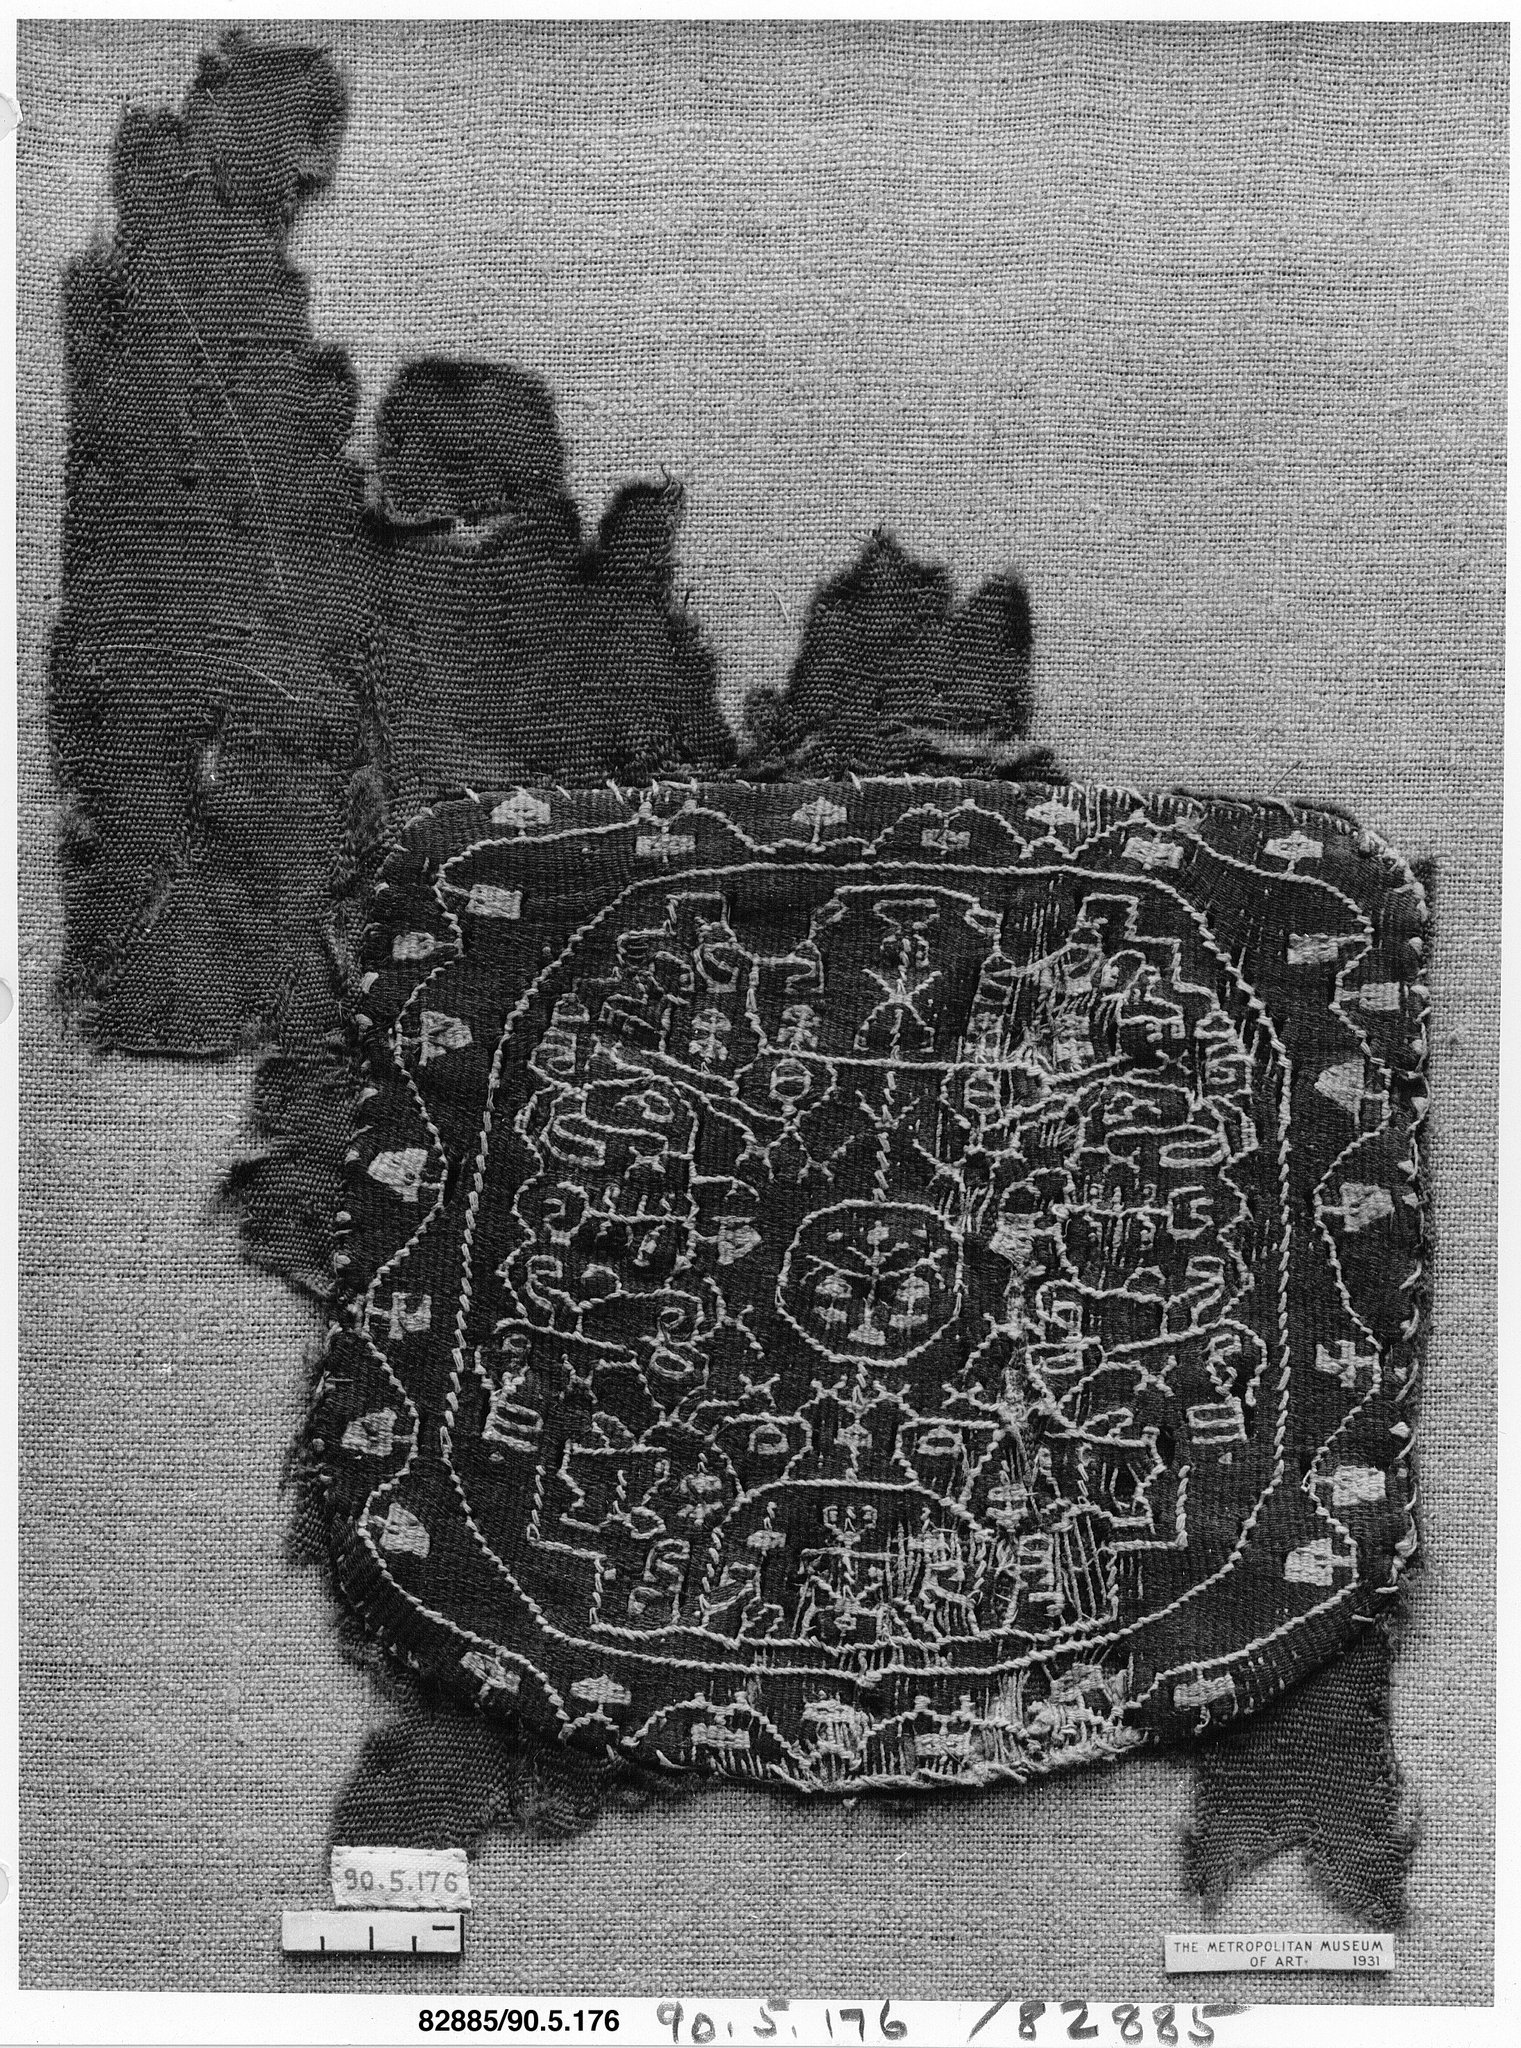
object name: textile fragment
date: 401-500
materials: linen, wool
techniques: weave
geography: egypt